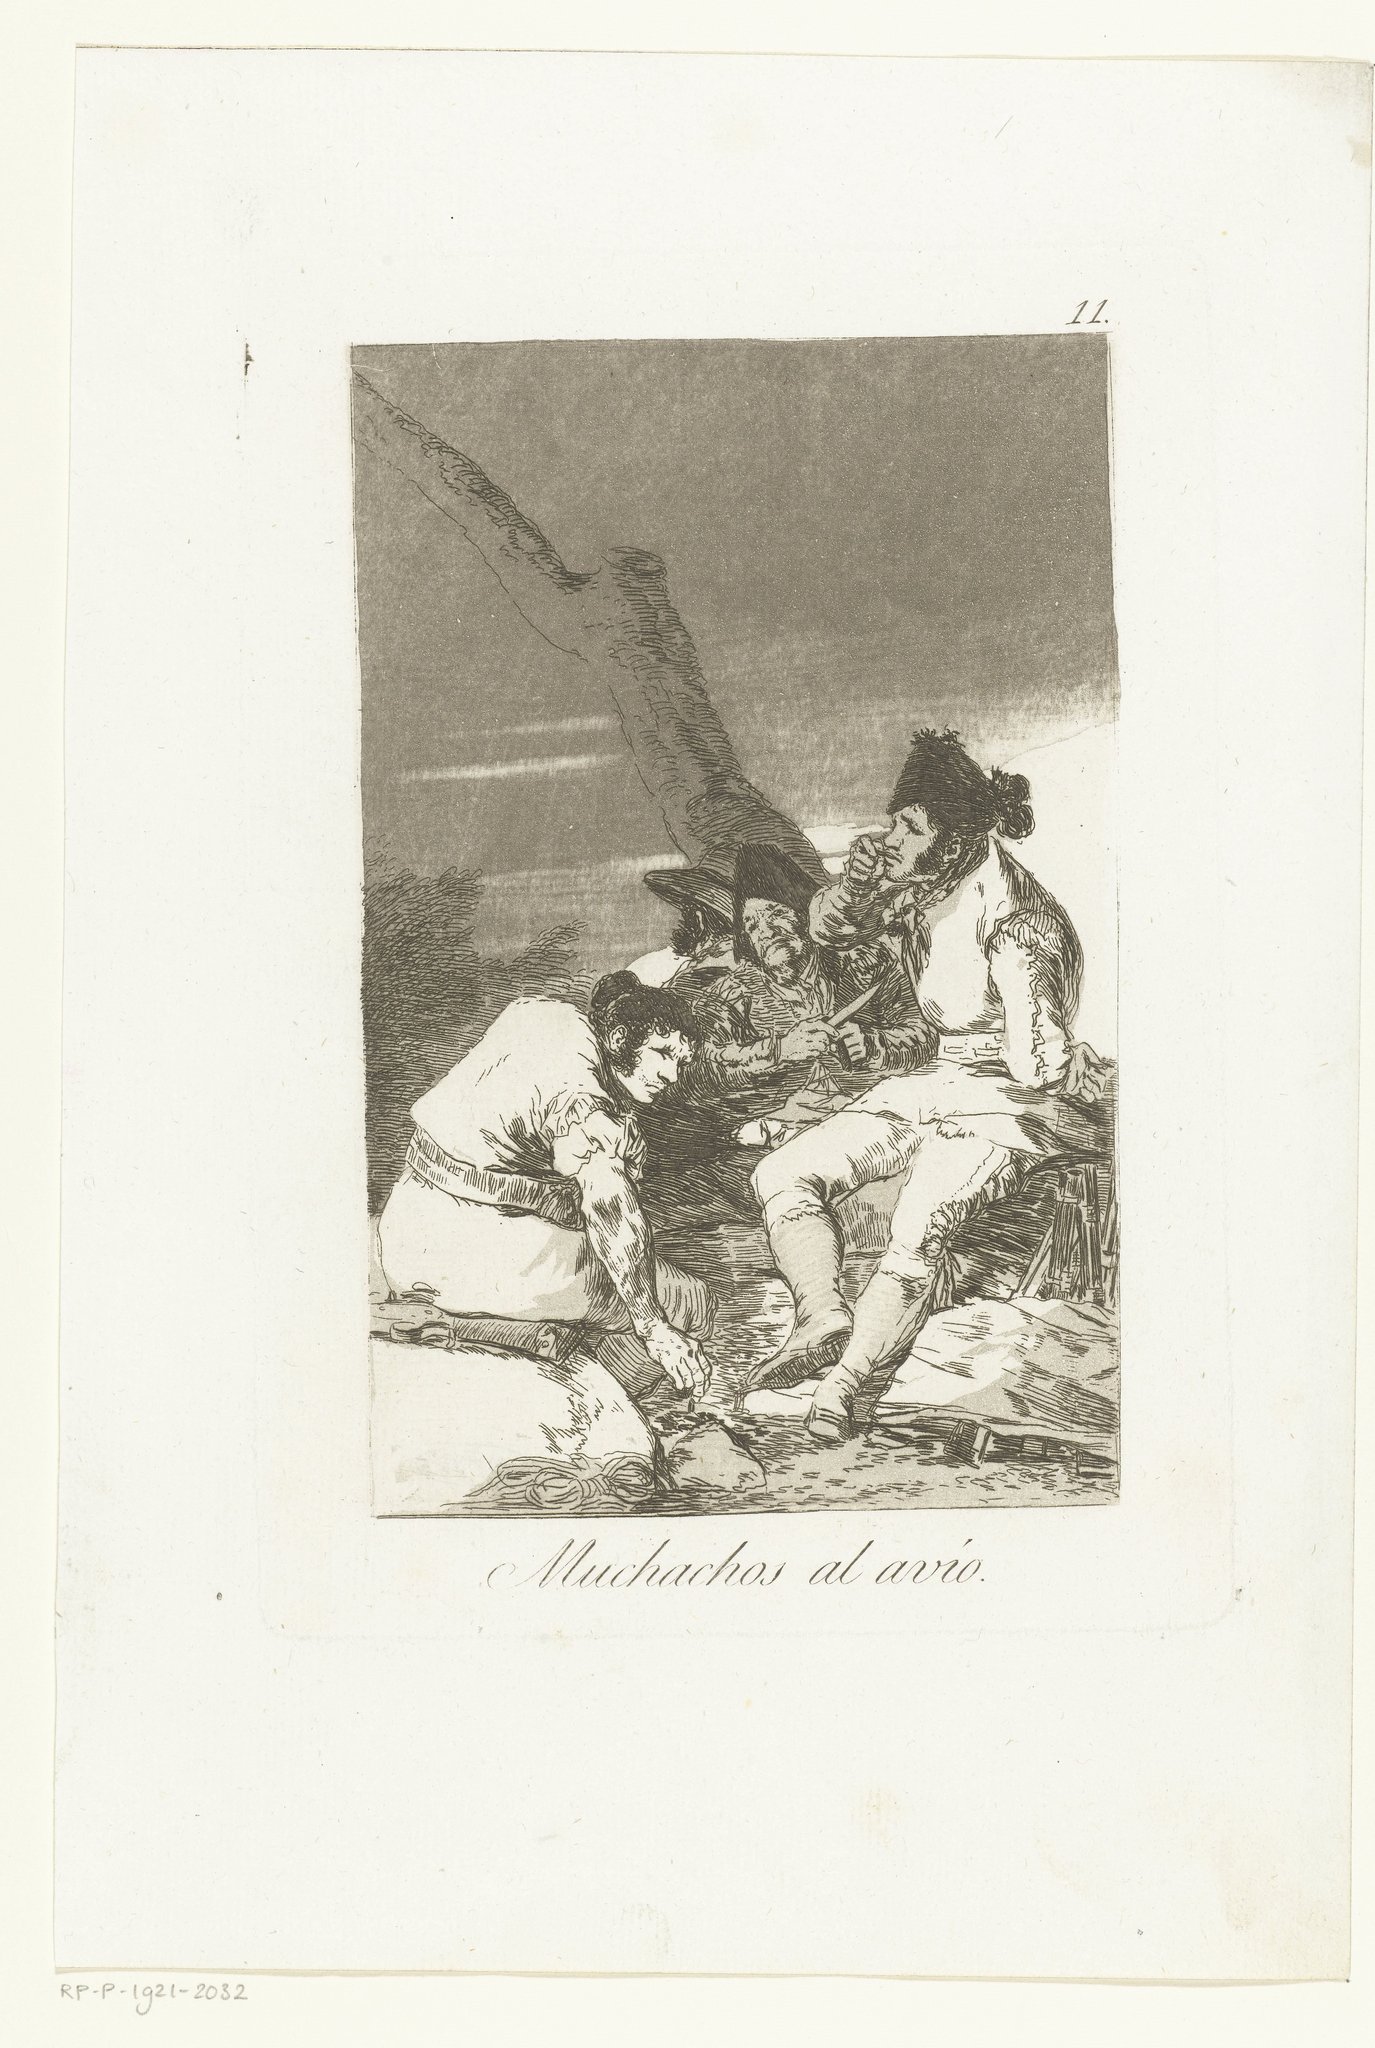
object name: print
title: Muchachos al avío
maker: francisco de goya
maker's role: draughtsman, painter, print maker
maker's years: 1746-1828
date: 1797-1799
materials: paper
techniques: aquatint, etching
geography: spain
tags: smuggler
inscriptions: collector's mark: Lugt 2228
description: Vier smokkelaars zitten bij een boom te wachten. Elfde prent uit de serie Los Caprichos.